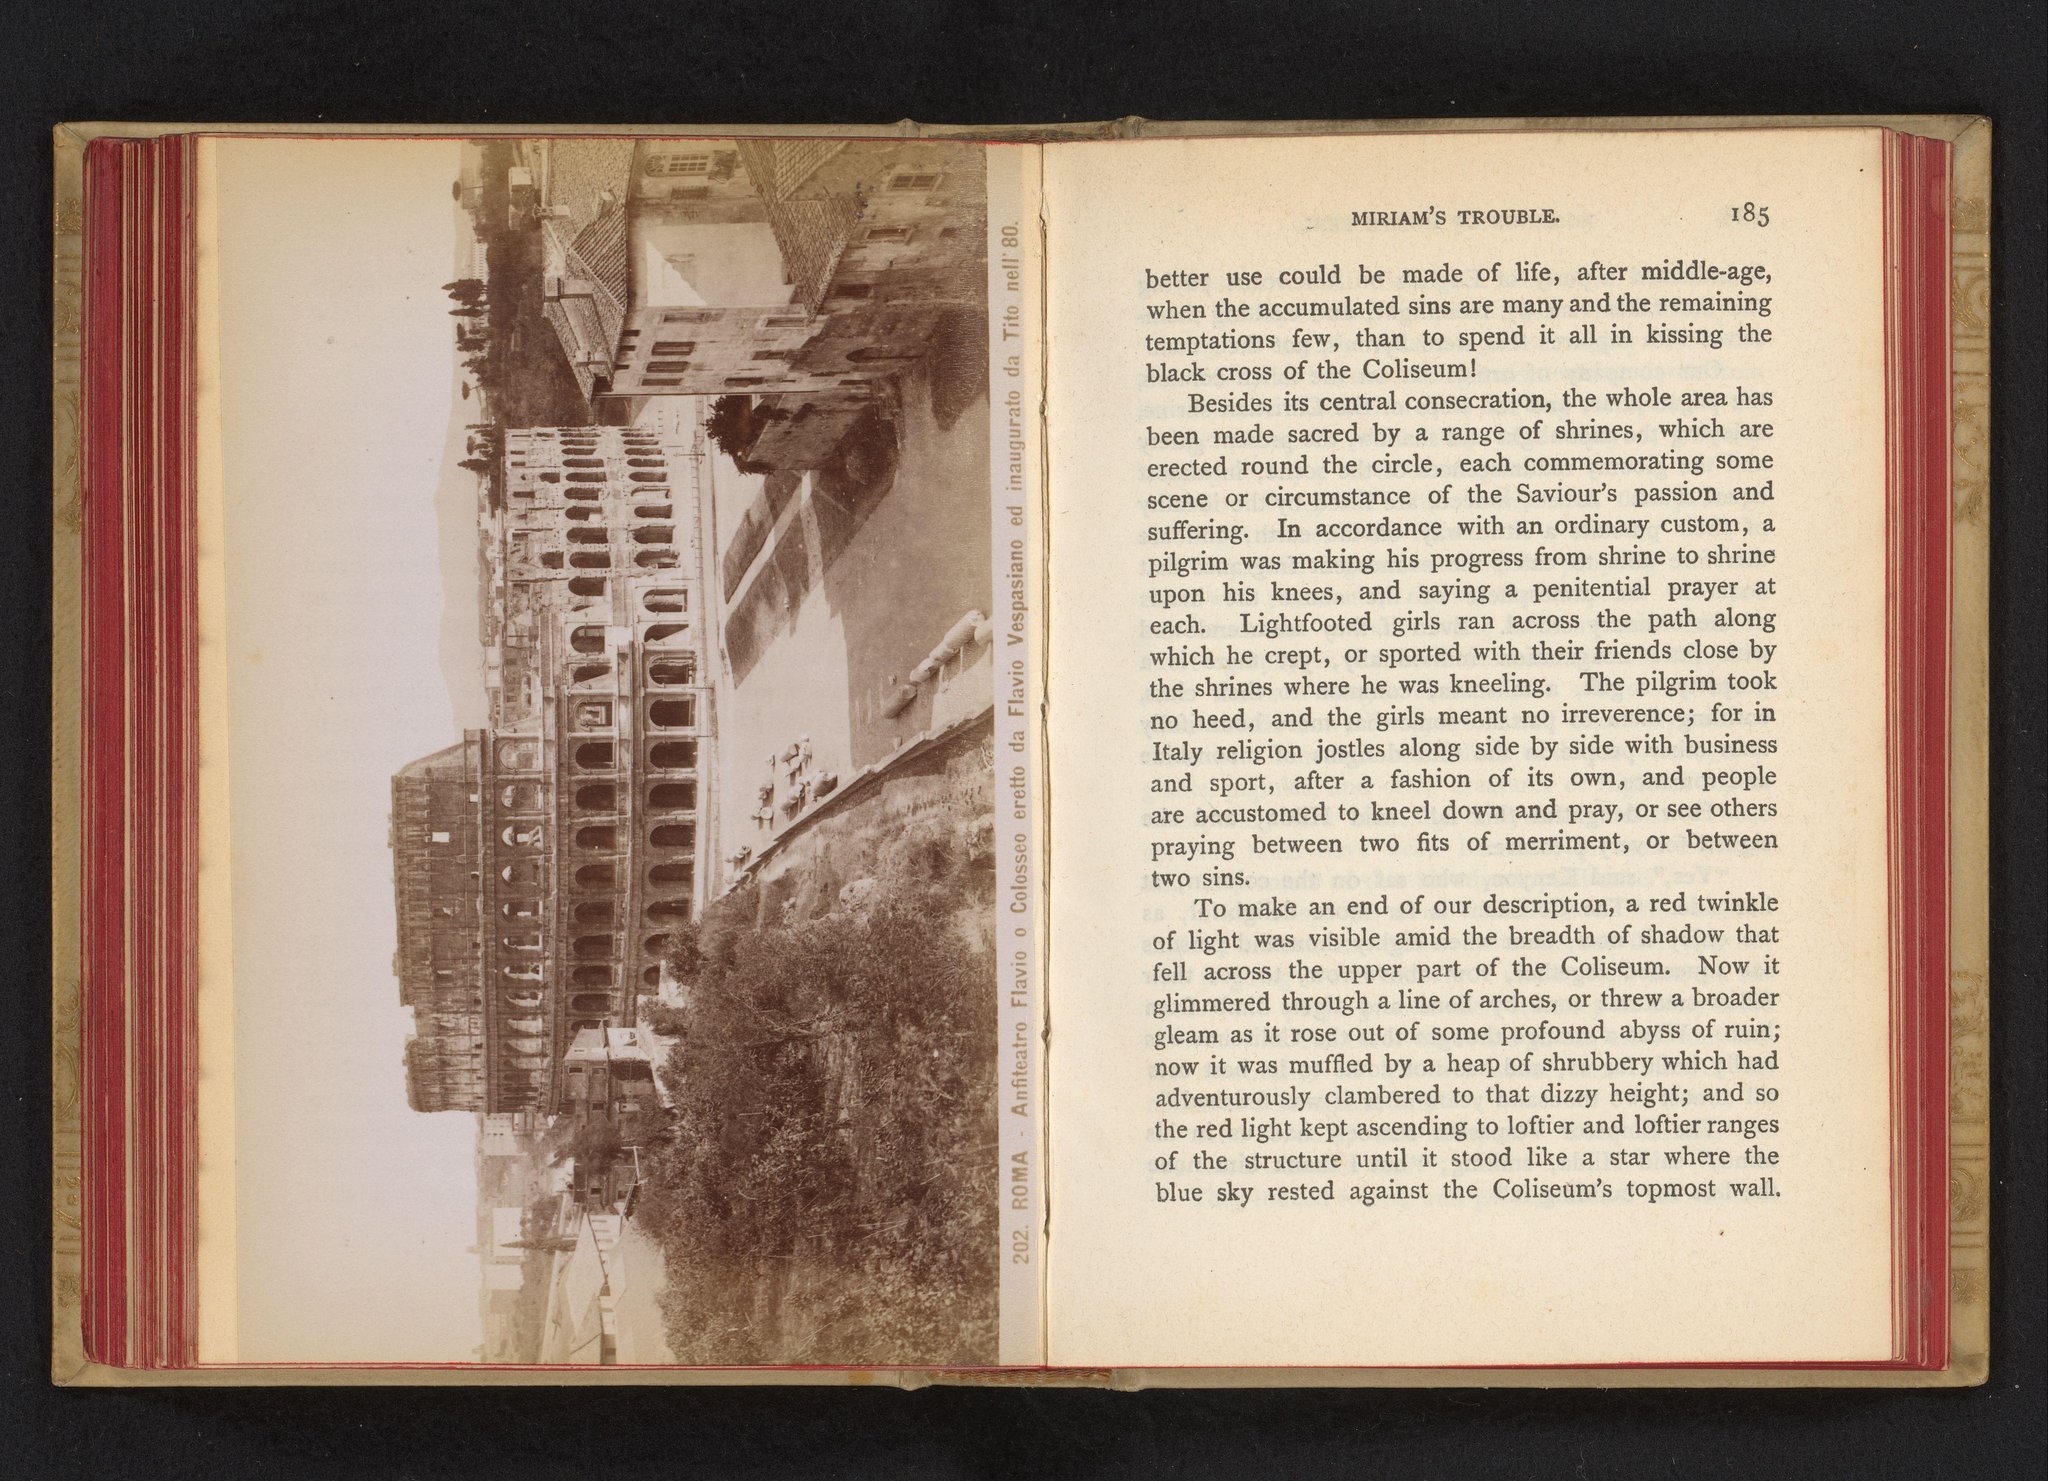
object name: photograph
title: Gezicht op het Colosseum te Rome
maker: Anonymous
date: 1855-1860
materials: paper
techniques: albumen print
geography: rome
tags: amphitheatre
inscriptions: number: ‘202.’